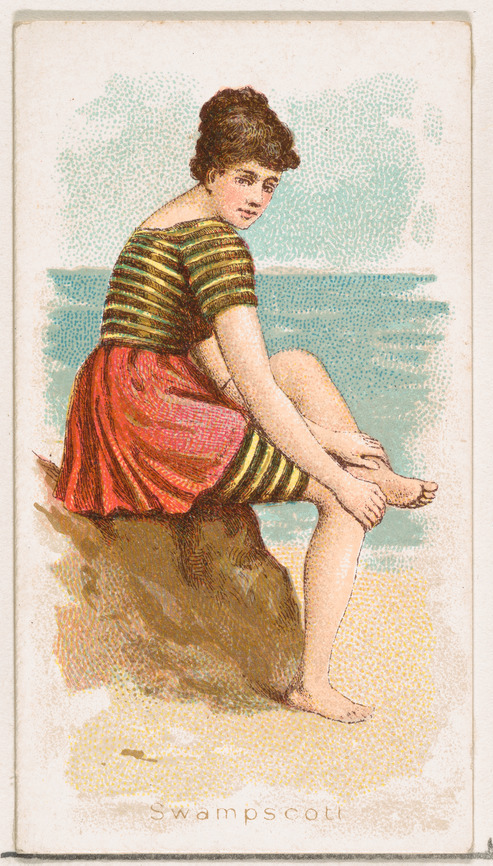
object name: print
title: Swampscott, from the Fancy Bathers series (N187) issued by Wm. S. Kimball & Co.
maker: william s. kimball & company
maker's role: publisher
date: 1889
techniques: color lithograph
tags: women